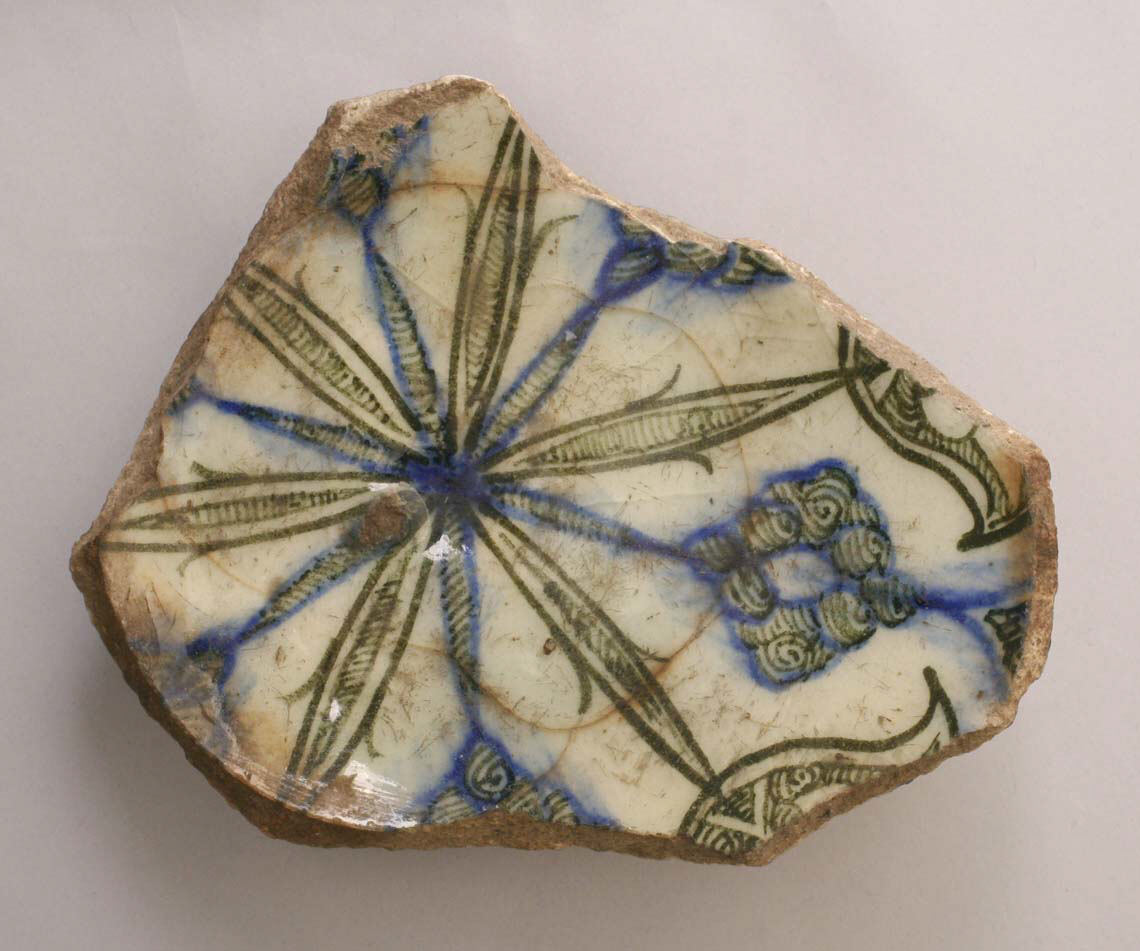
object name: fragment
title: Ceramic Fragment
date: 1301-1400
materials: glaze, stonepaste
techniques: painting, polychrome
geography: syria